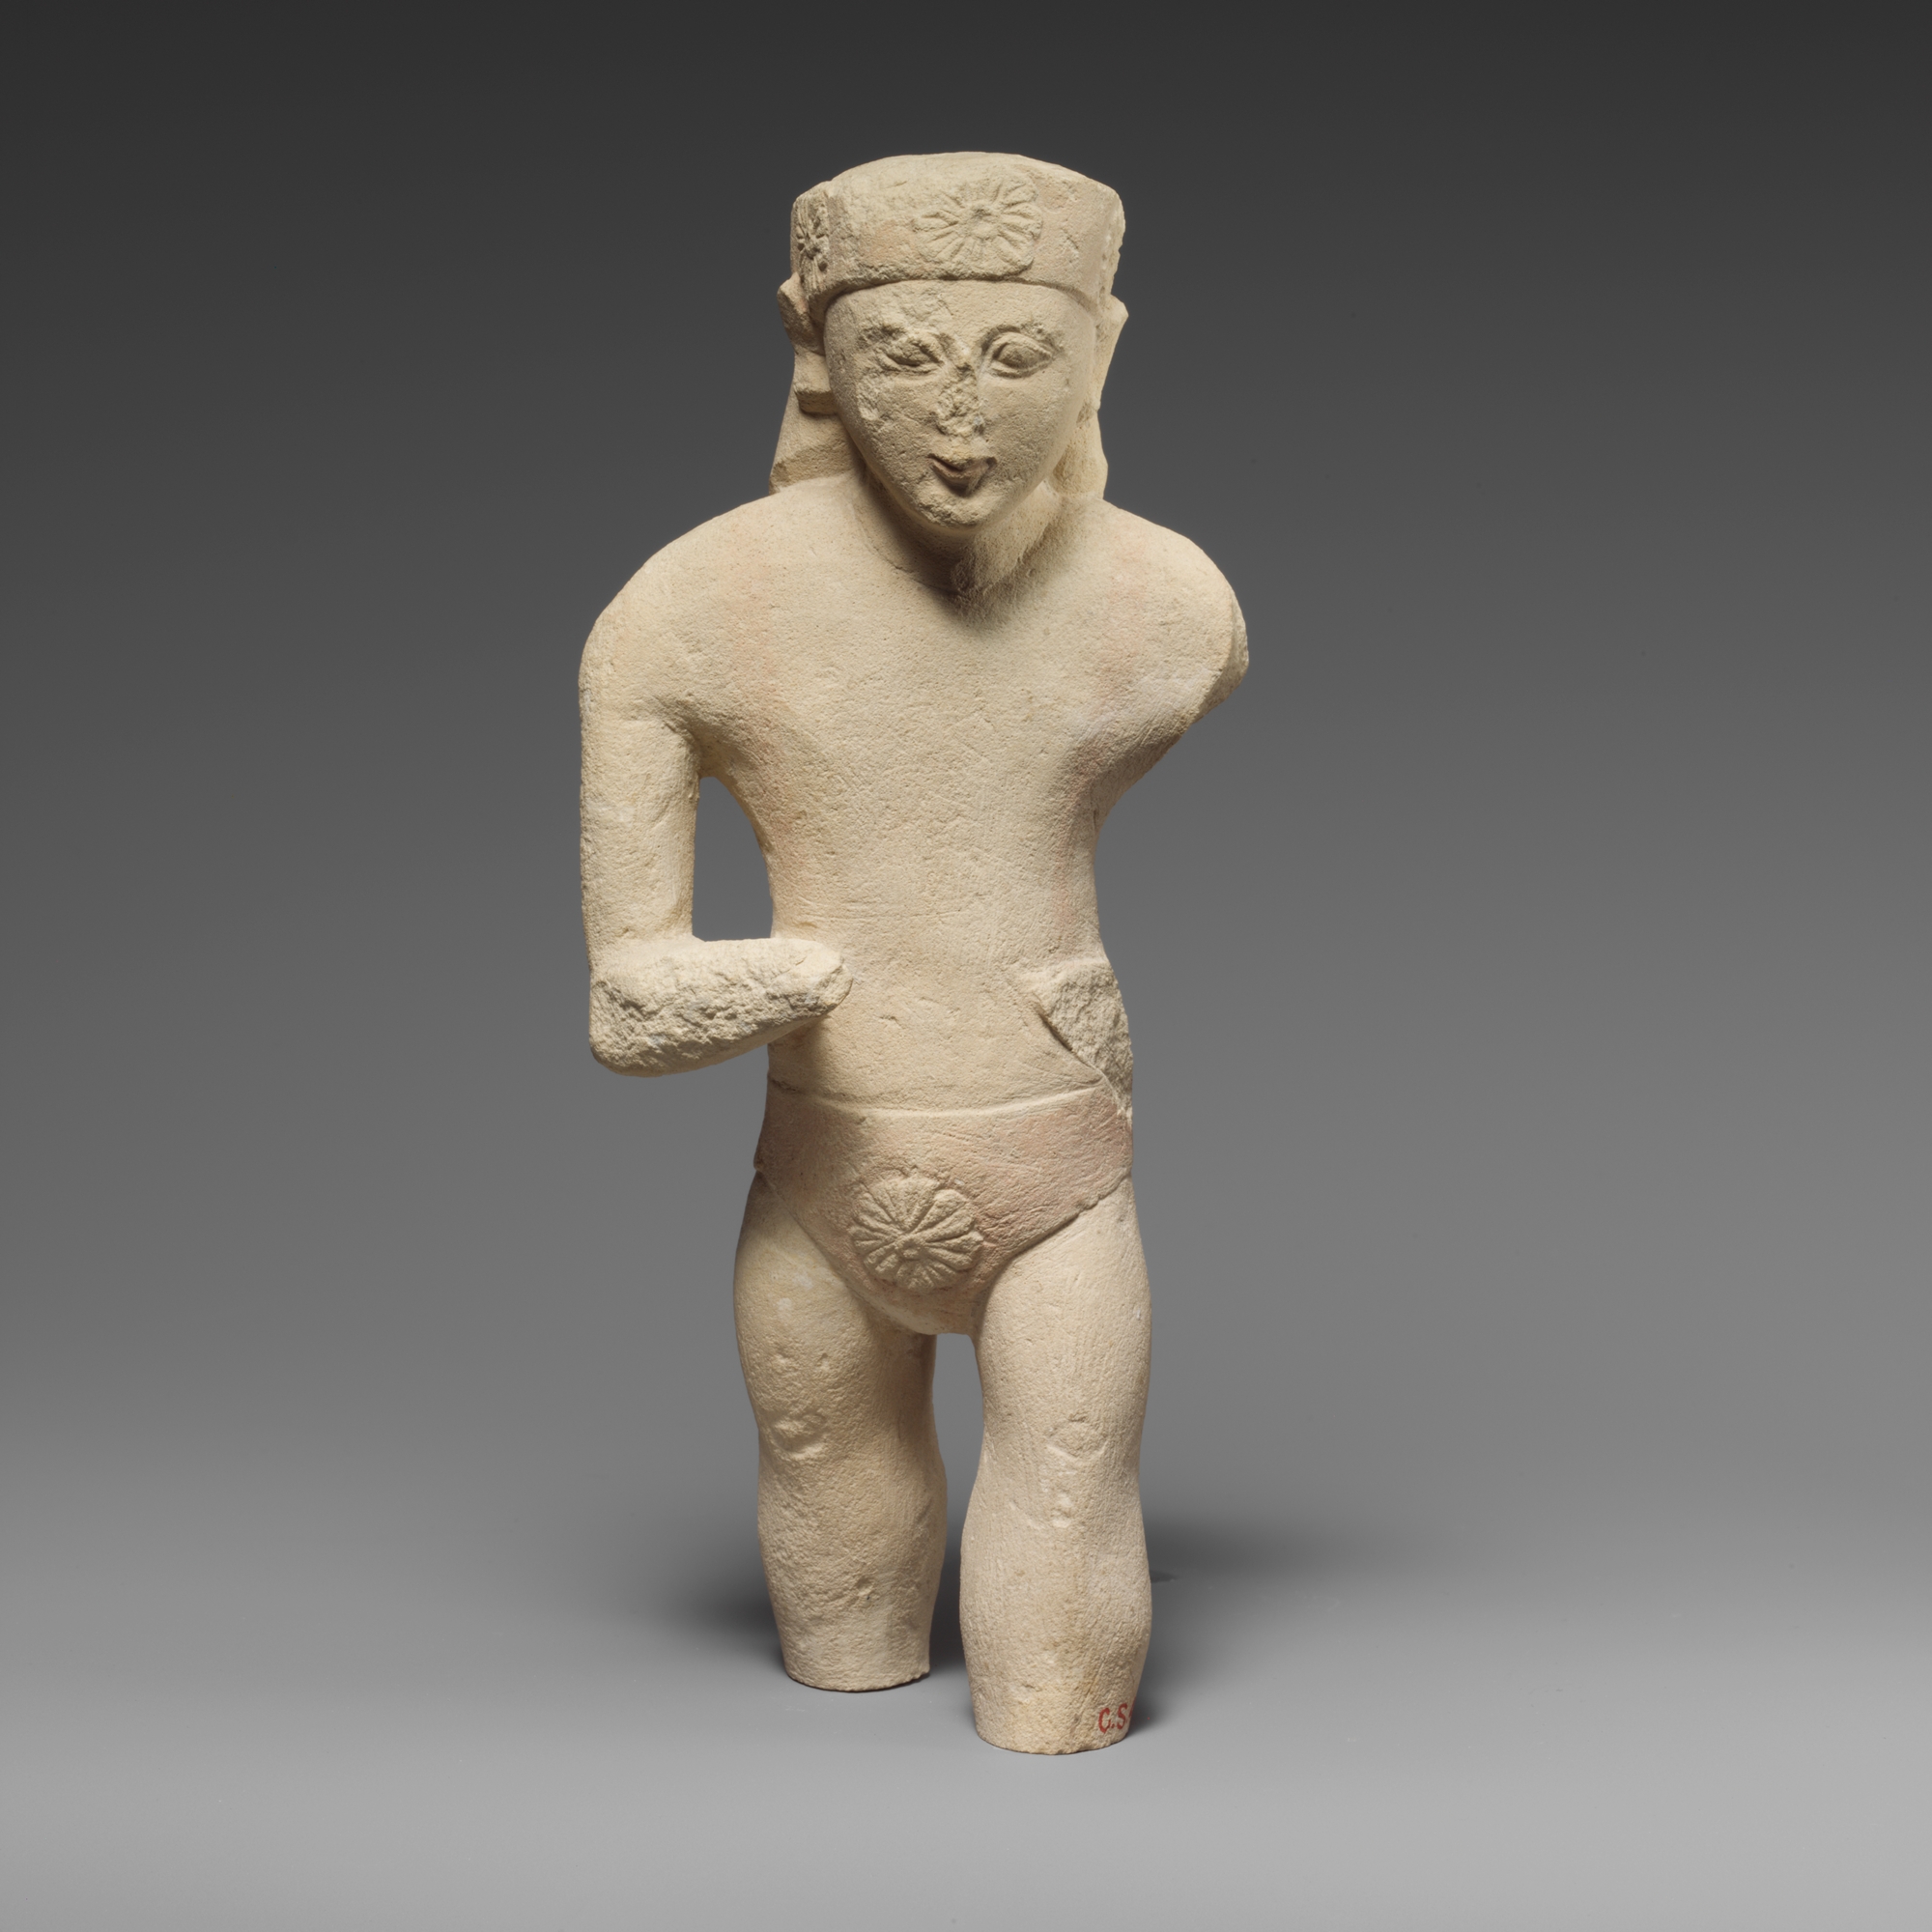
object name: statue of a votary, male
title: Limestone statuette of a male votary with Cypriot shorts and a diadem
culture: cypriot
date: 600-551 BCE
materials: limestone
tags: diadems,men